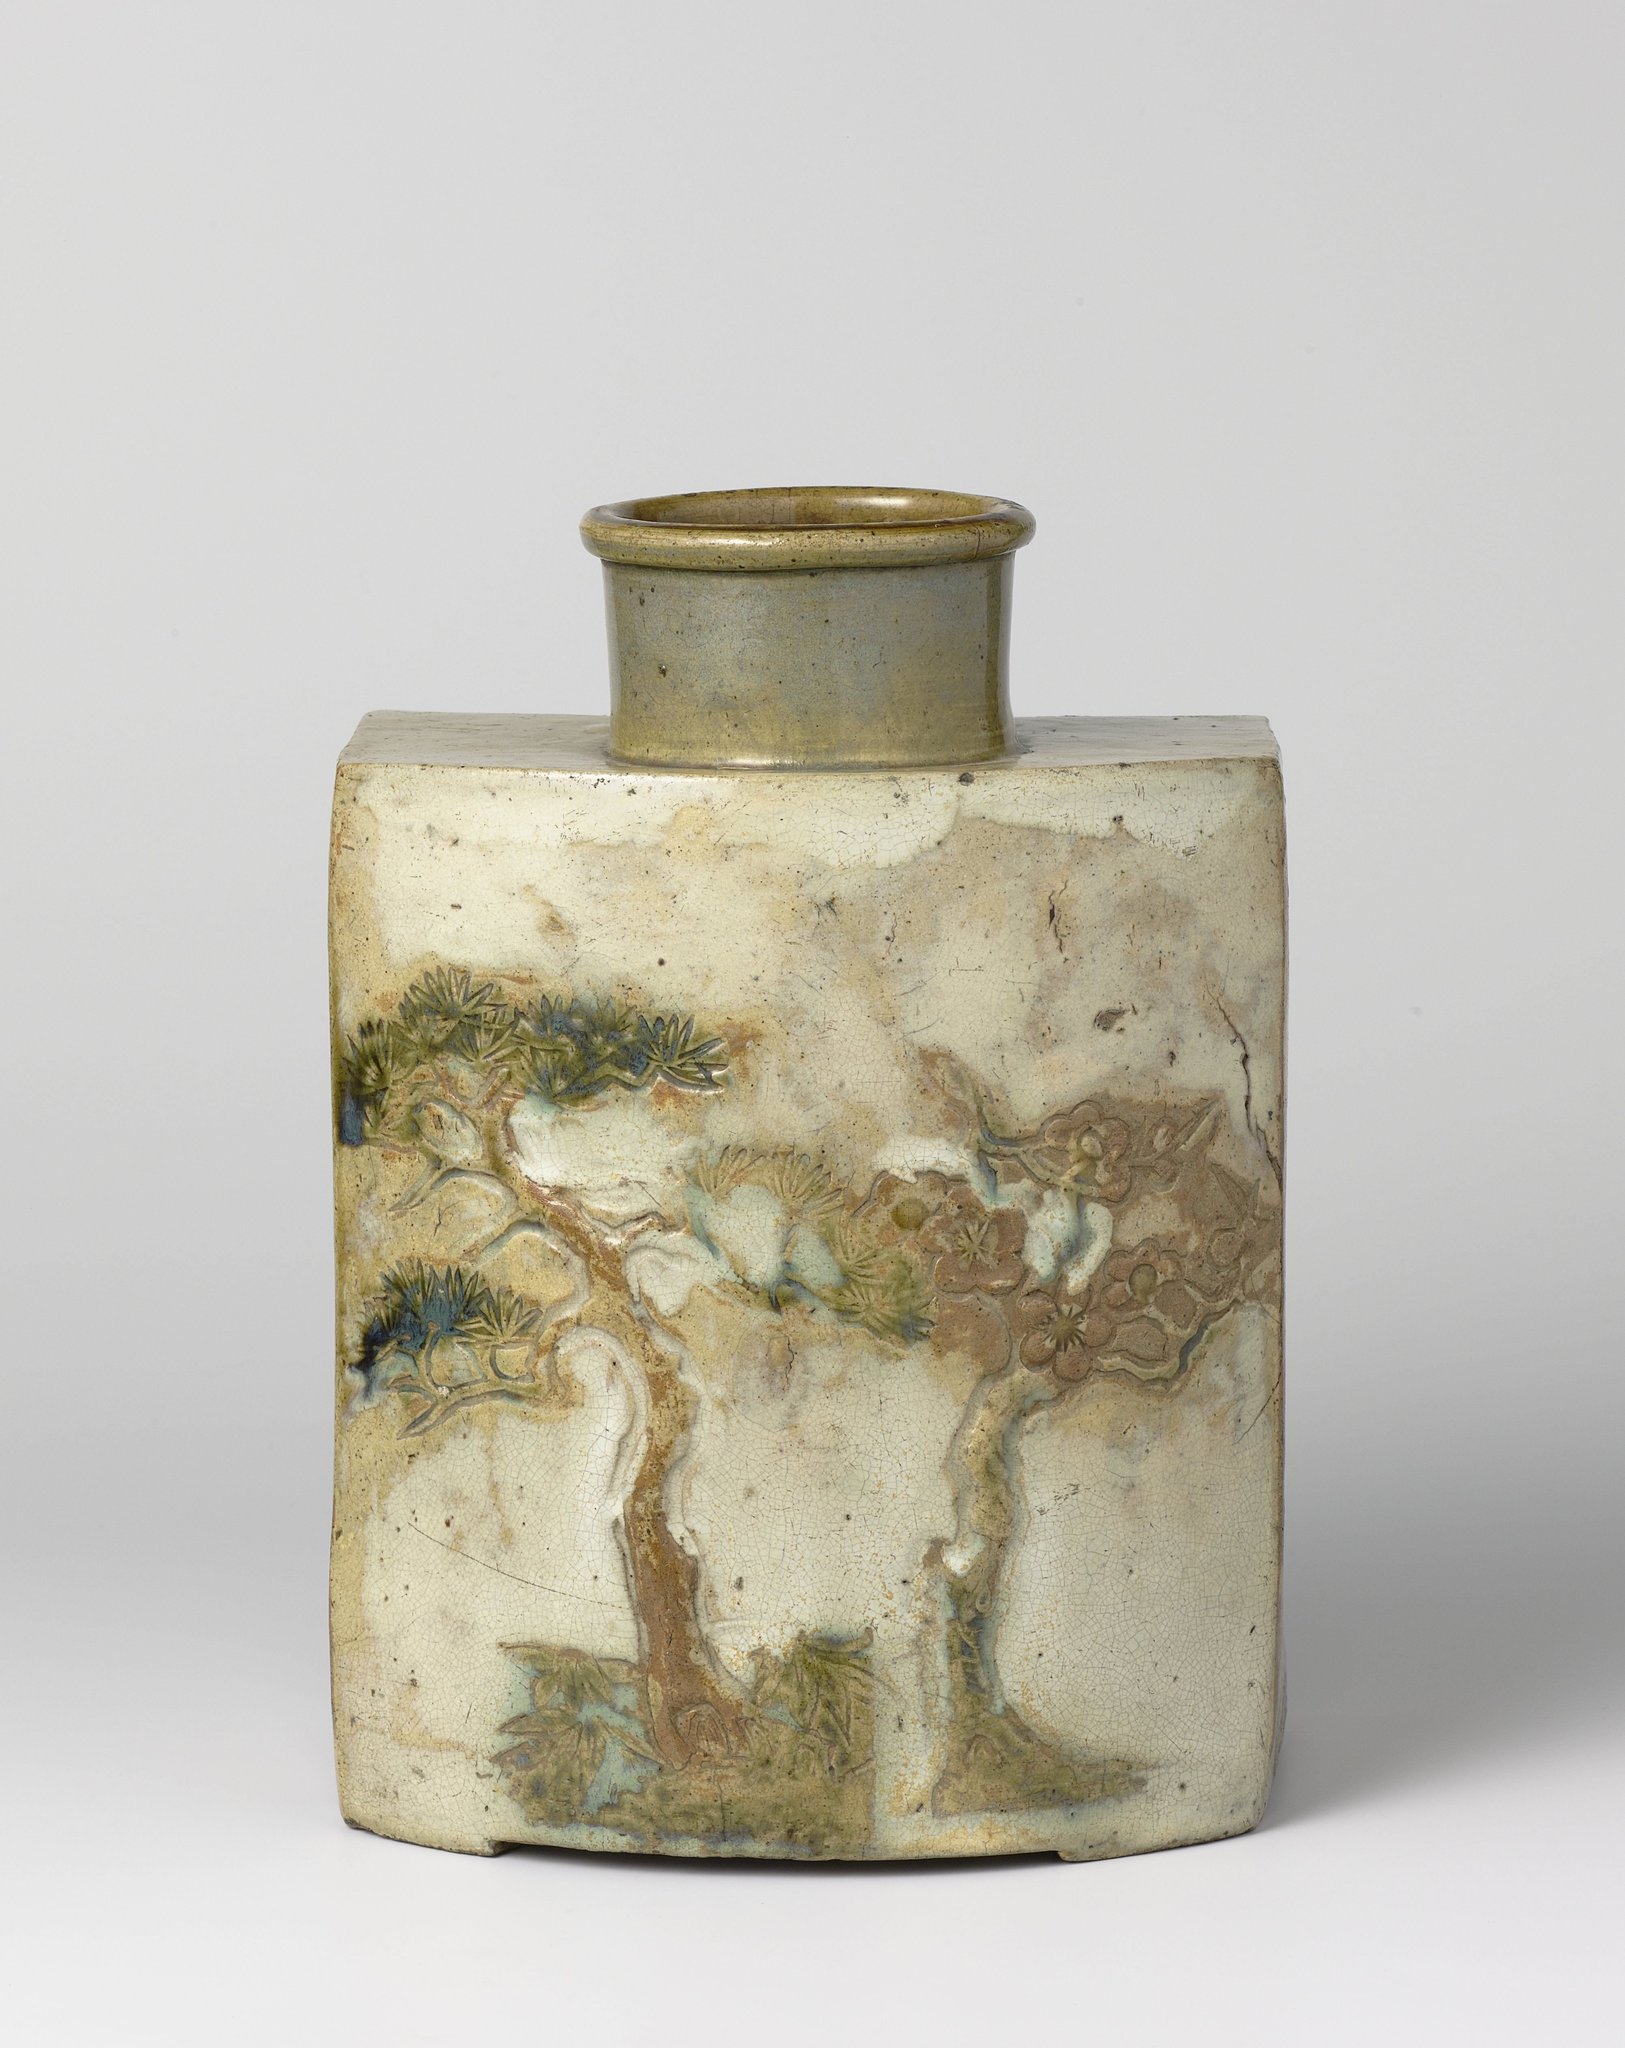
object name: vase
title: Rounded, rectagonal vase with flowering plants in relief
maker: Anonymous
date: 1700-1799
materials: glaze, stoneware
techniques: firing, forming, relief, vitrification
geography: satsuma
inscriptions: label: ‘B.H. Benson Esq’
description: Halfronde, rechthoekige vaas van steengoed met een korte, wijde nek, bedekt met een wit slib, groen en bruin glazuur. Op de brede wanden gemodelleerde bloeiende planten. De bolle wand met een pijnboom en een prunus, de holle wand met een lotus. Oud label verzamelaarslabel op de onderzijde met 'B.H. Benson Esq'. Satsuma.